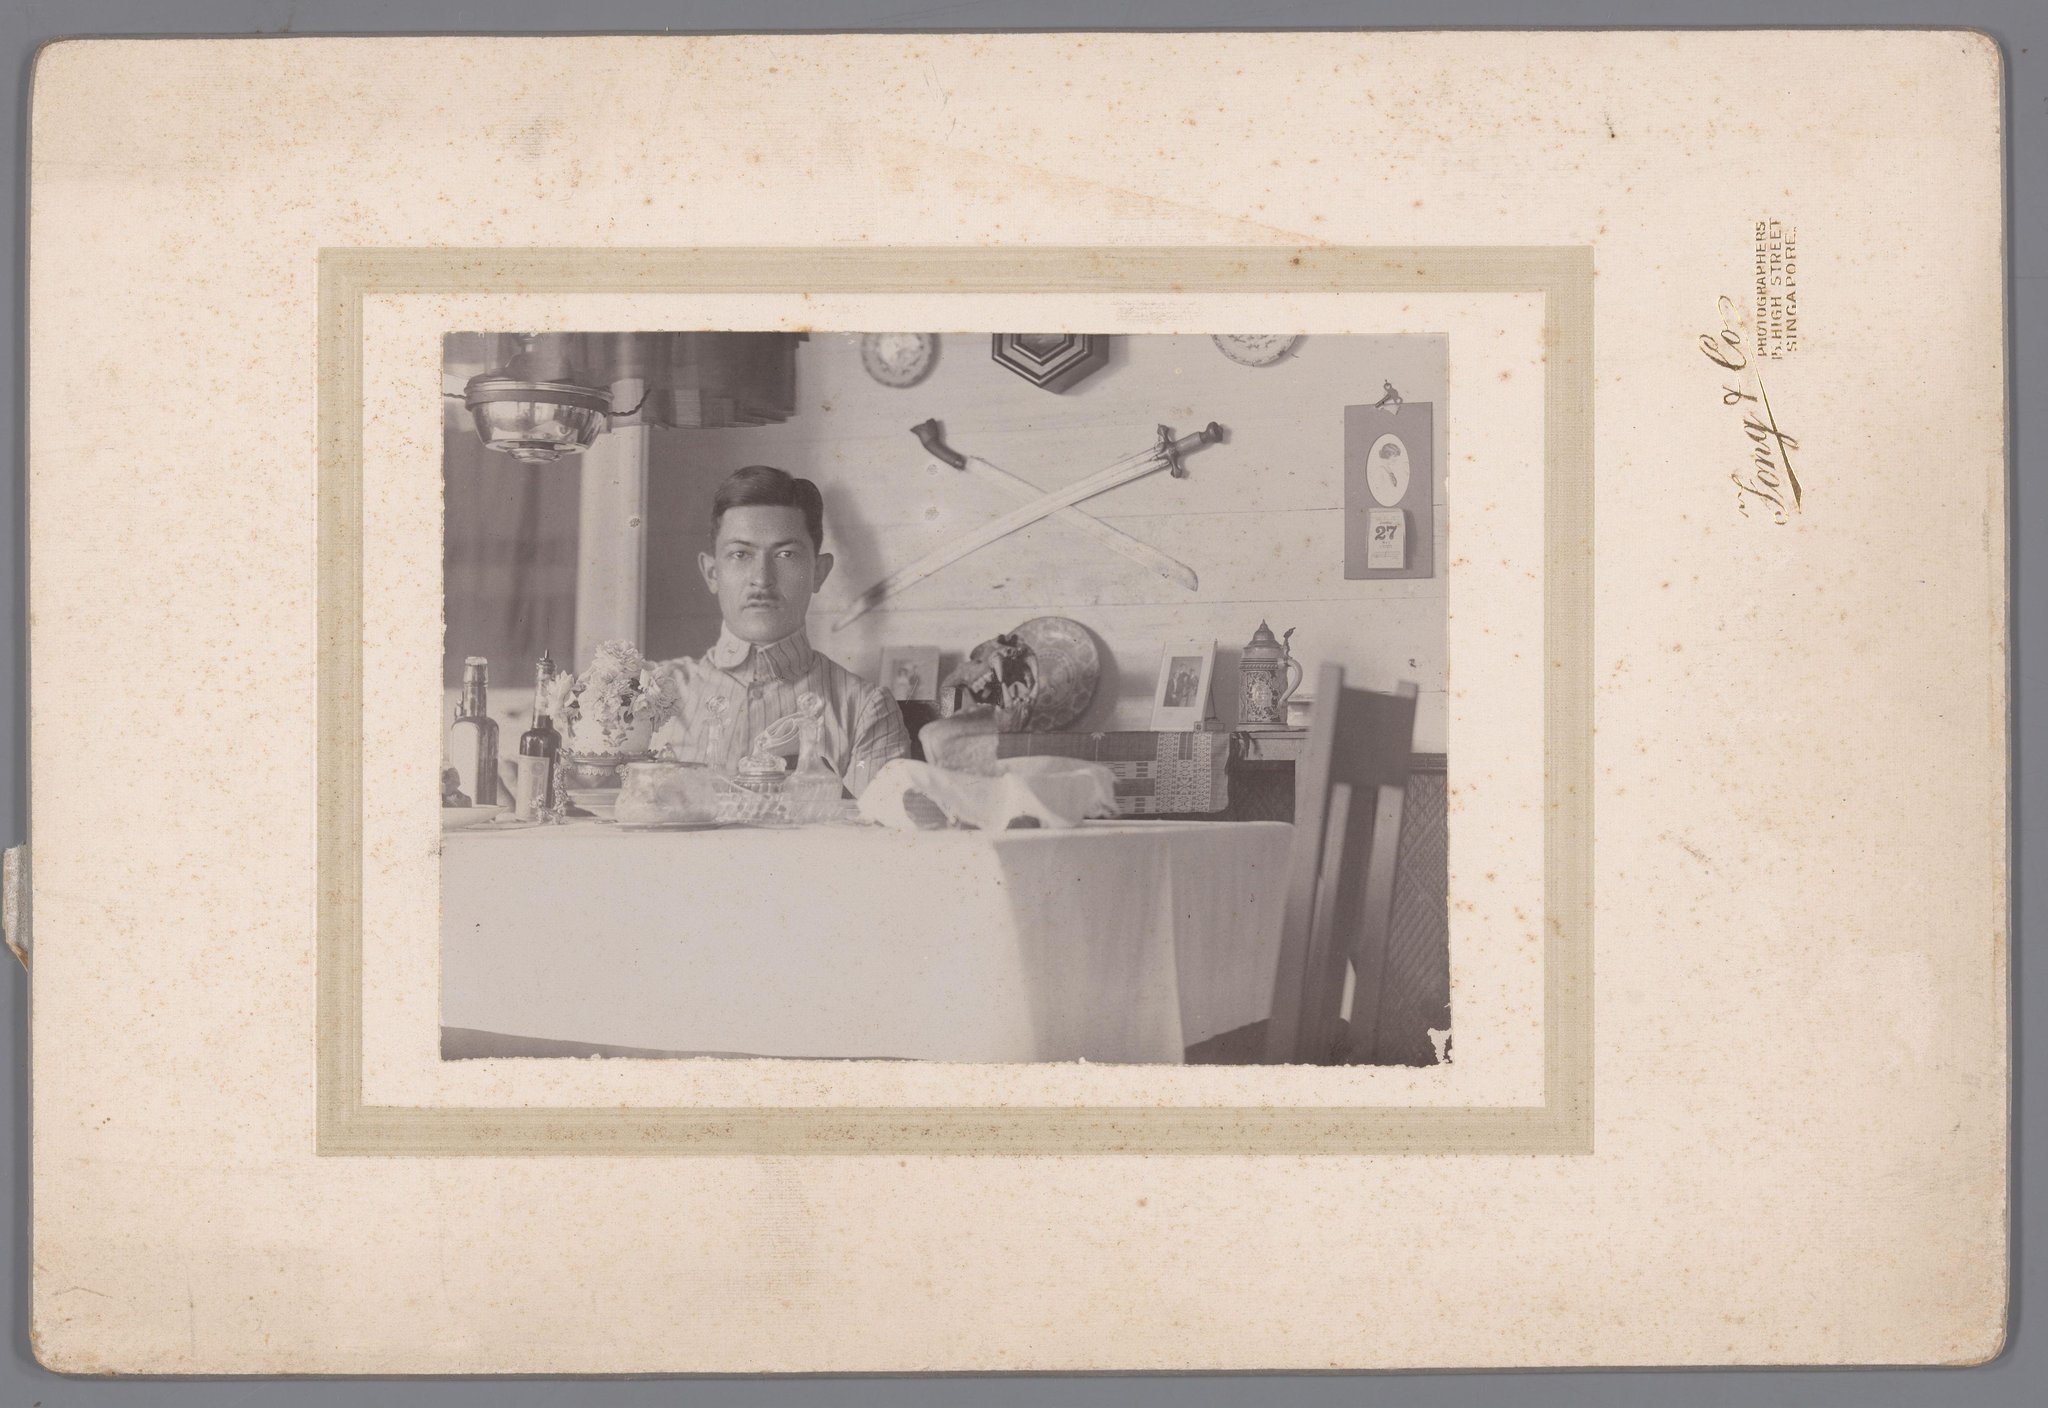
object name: photograph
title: Portret van een onbekende man achter een tafel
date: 1913-1920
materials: paper, cardboard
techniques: collodion silver print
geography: singapore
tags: adult man, anonymous historical person portrayed, singapore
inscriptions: address: ‘15, HIGH STREET/ SINGAPORE.’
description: Zie gerelateerde objecten voor andere foto's van dezelfde man.